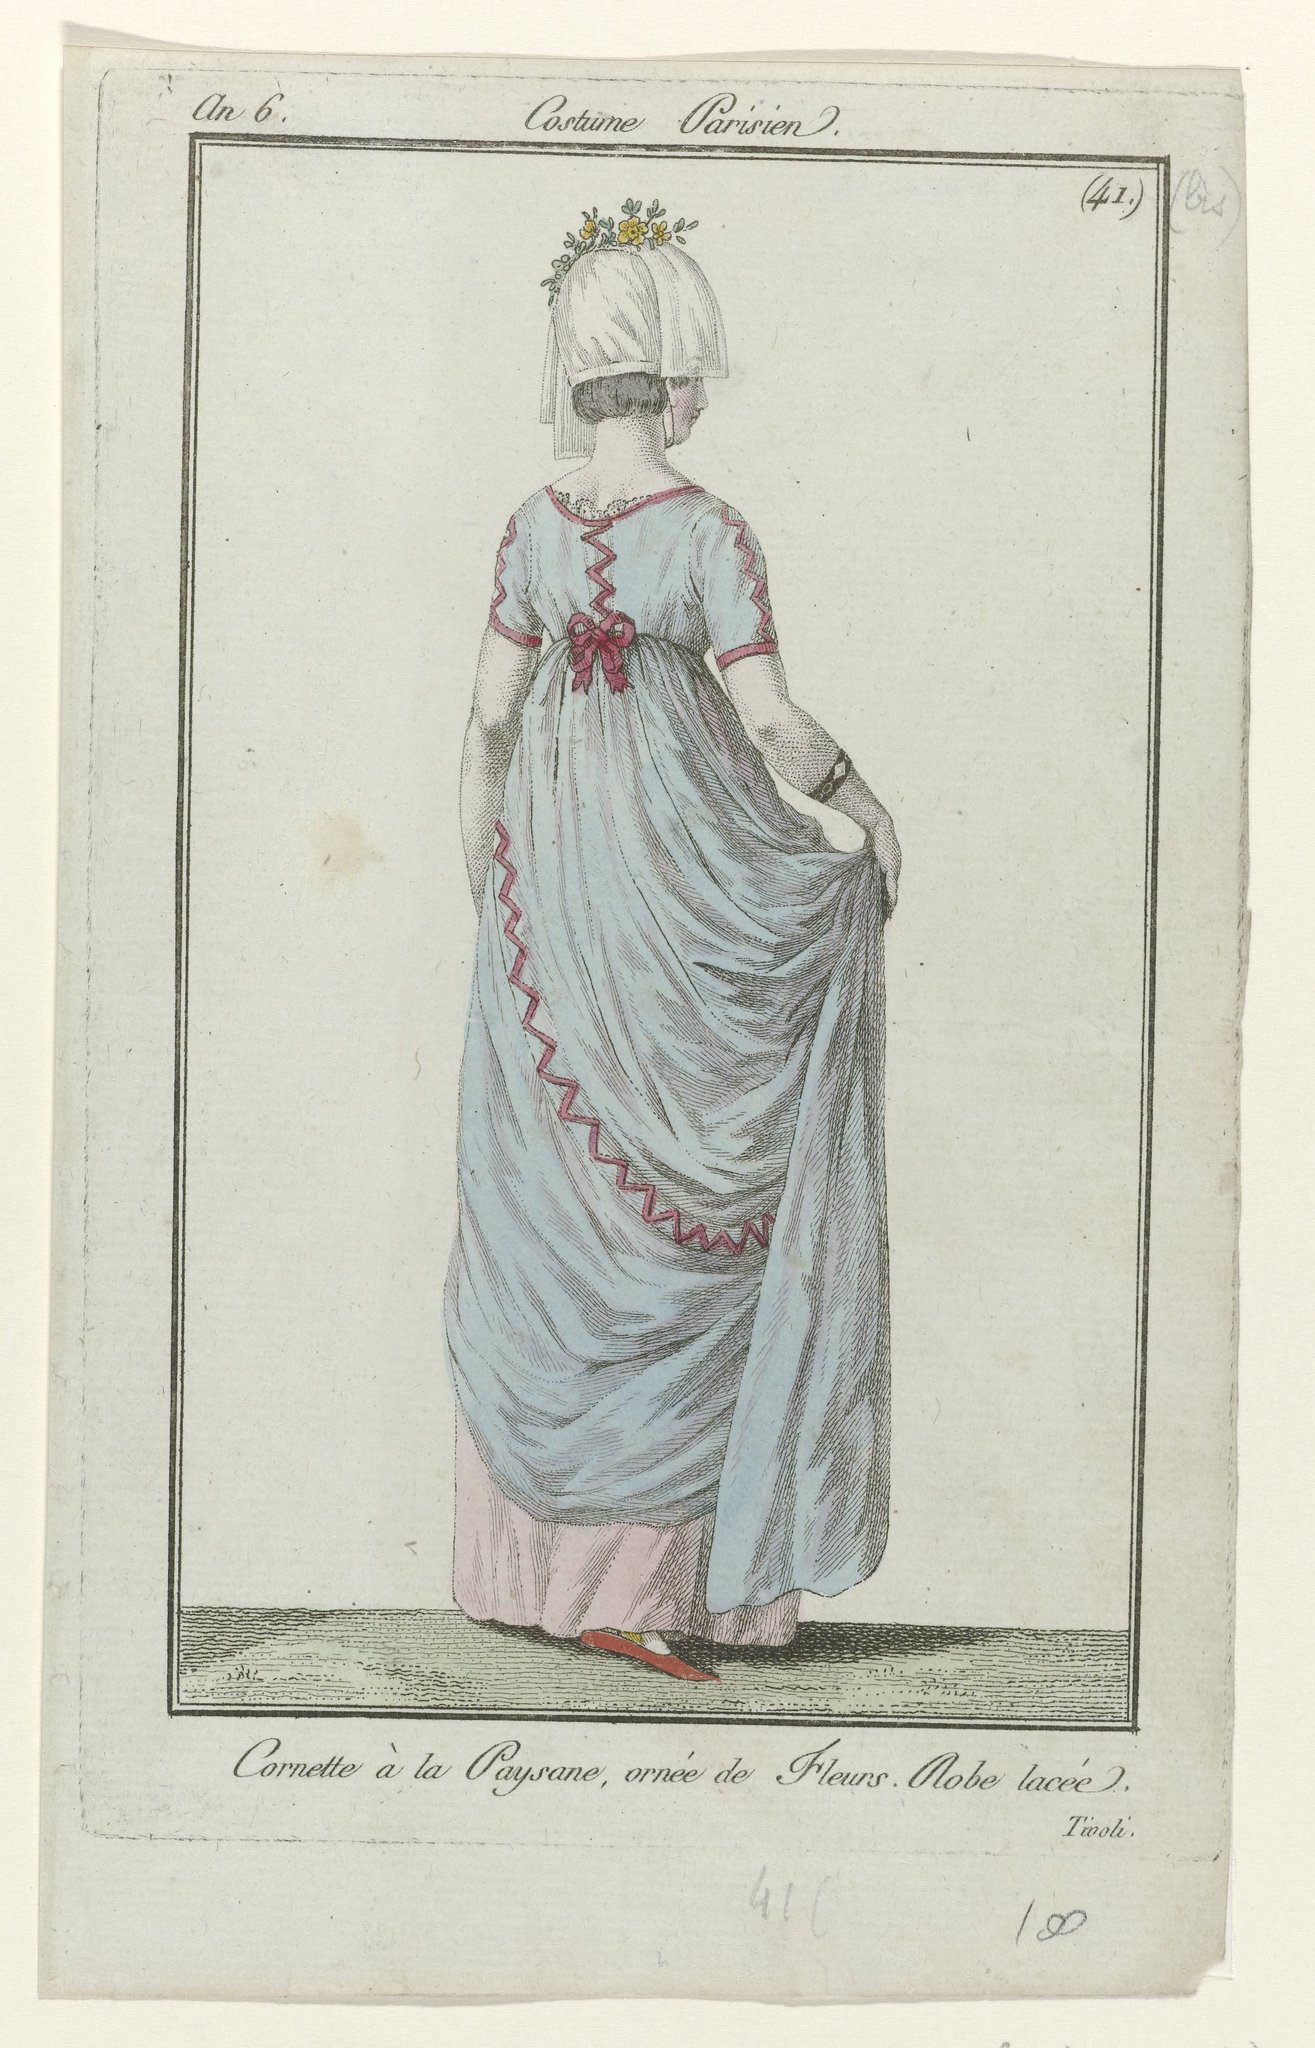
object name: fashion print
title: Journal des Dames et des Modes, Costume Parisien, 2 juin 1798, An 6, (41 (bis)): Cornette à la Paysan (...)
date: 1798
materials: paper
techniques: engraving, hand coloring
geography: paris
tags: border, ribbon, braid (+ women's clothes), head-gear (cornette) (+ women's clothes), fashion plates, shoes, sandals (+ women's clothes), dress, gown (+ women's clothes), bracelet, wristlet (+ women's clothes)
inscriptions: caption: ‘Cornette à la Paysane, ornée de Fleurs. Robe lacée. / Tivoli’, title: ‘Costume Parisien.’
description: 'Cornette à la Paysane', versierd met bloemen. Japon met korte mouwen, rijgsluiting en strik. Onder de opgetrokken japon is haar 'chemise'(?) te zien. Verdere accessoires: armband om de rechterpols, kous, platte schoen met puntige neus. Volgens het onderschrift is deze voorstelling naar het leven getekend in 'Tivoli'. De prent maakt deel uit van het modetijdschrift Journal des Dames et des Modes, uitgegeven door Sellèque, Parijs, 1797-1839.